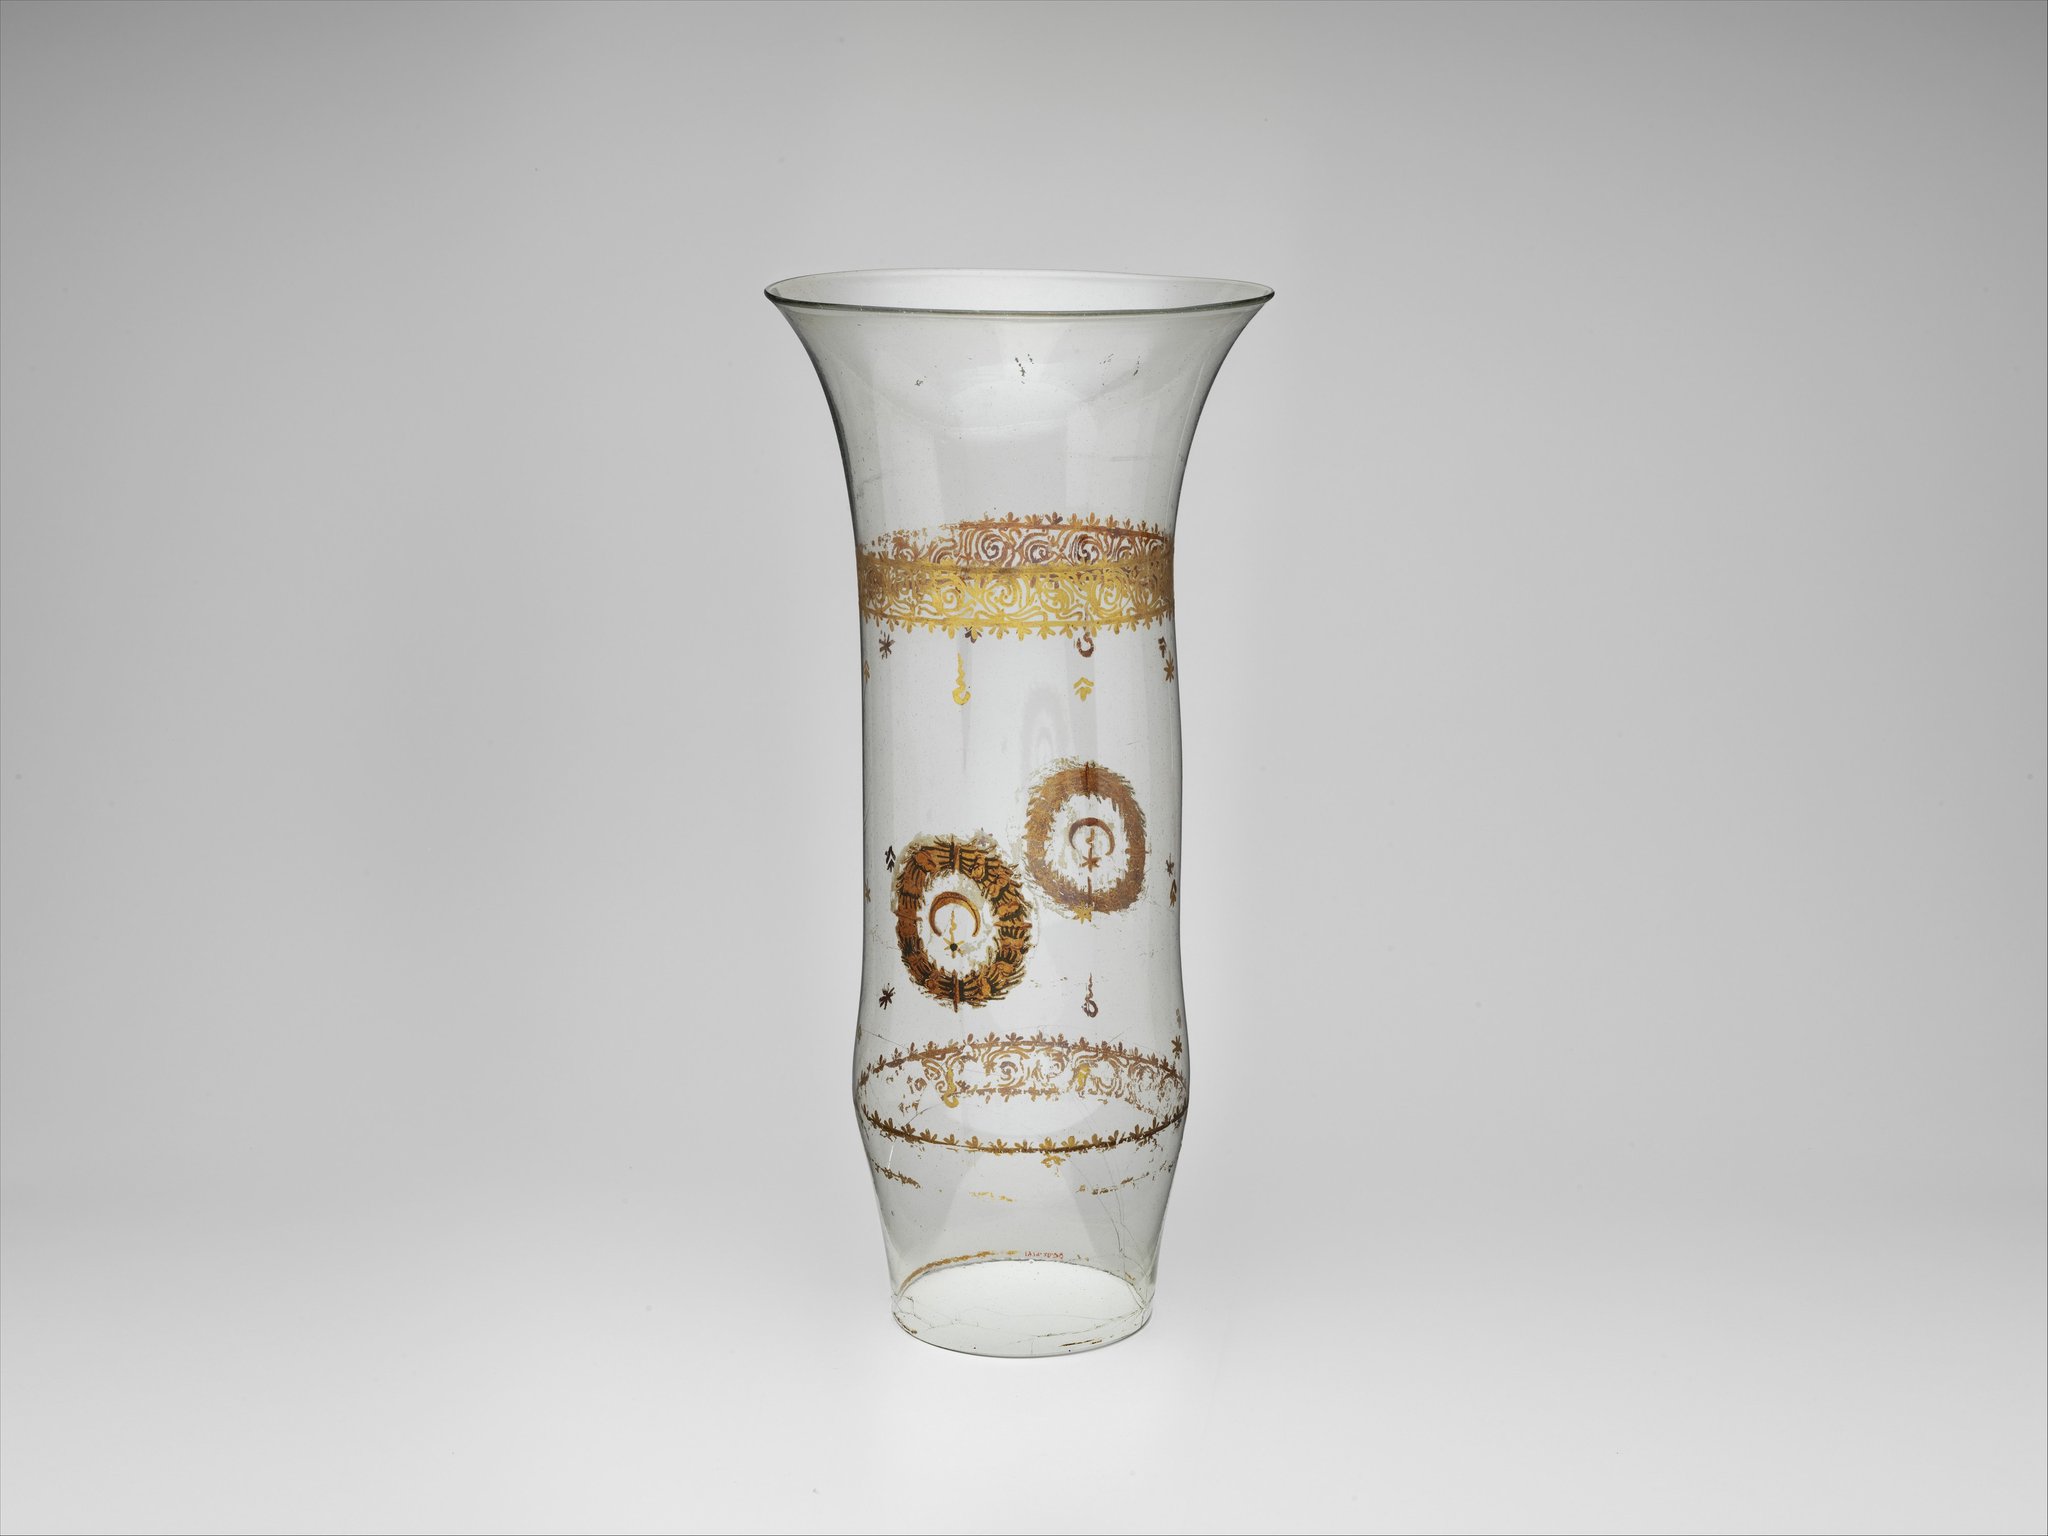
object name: storm shade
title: Storm shade (one of a pair)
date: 1560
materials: glass